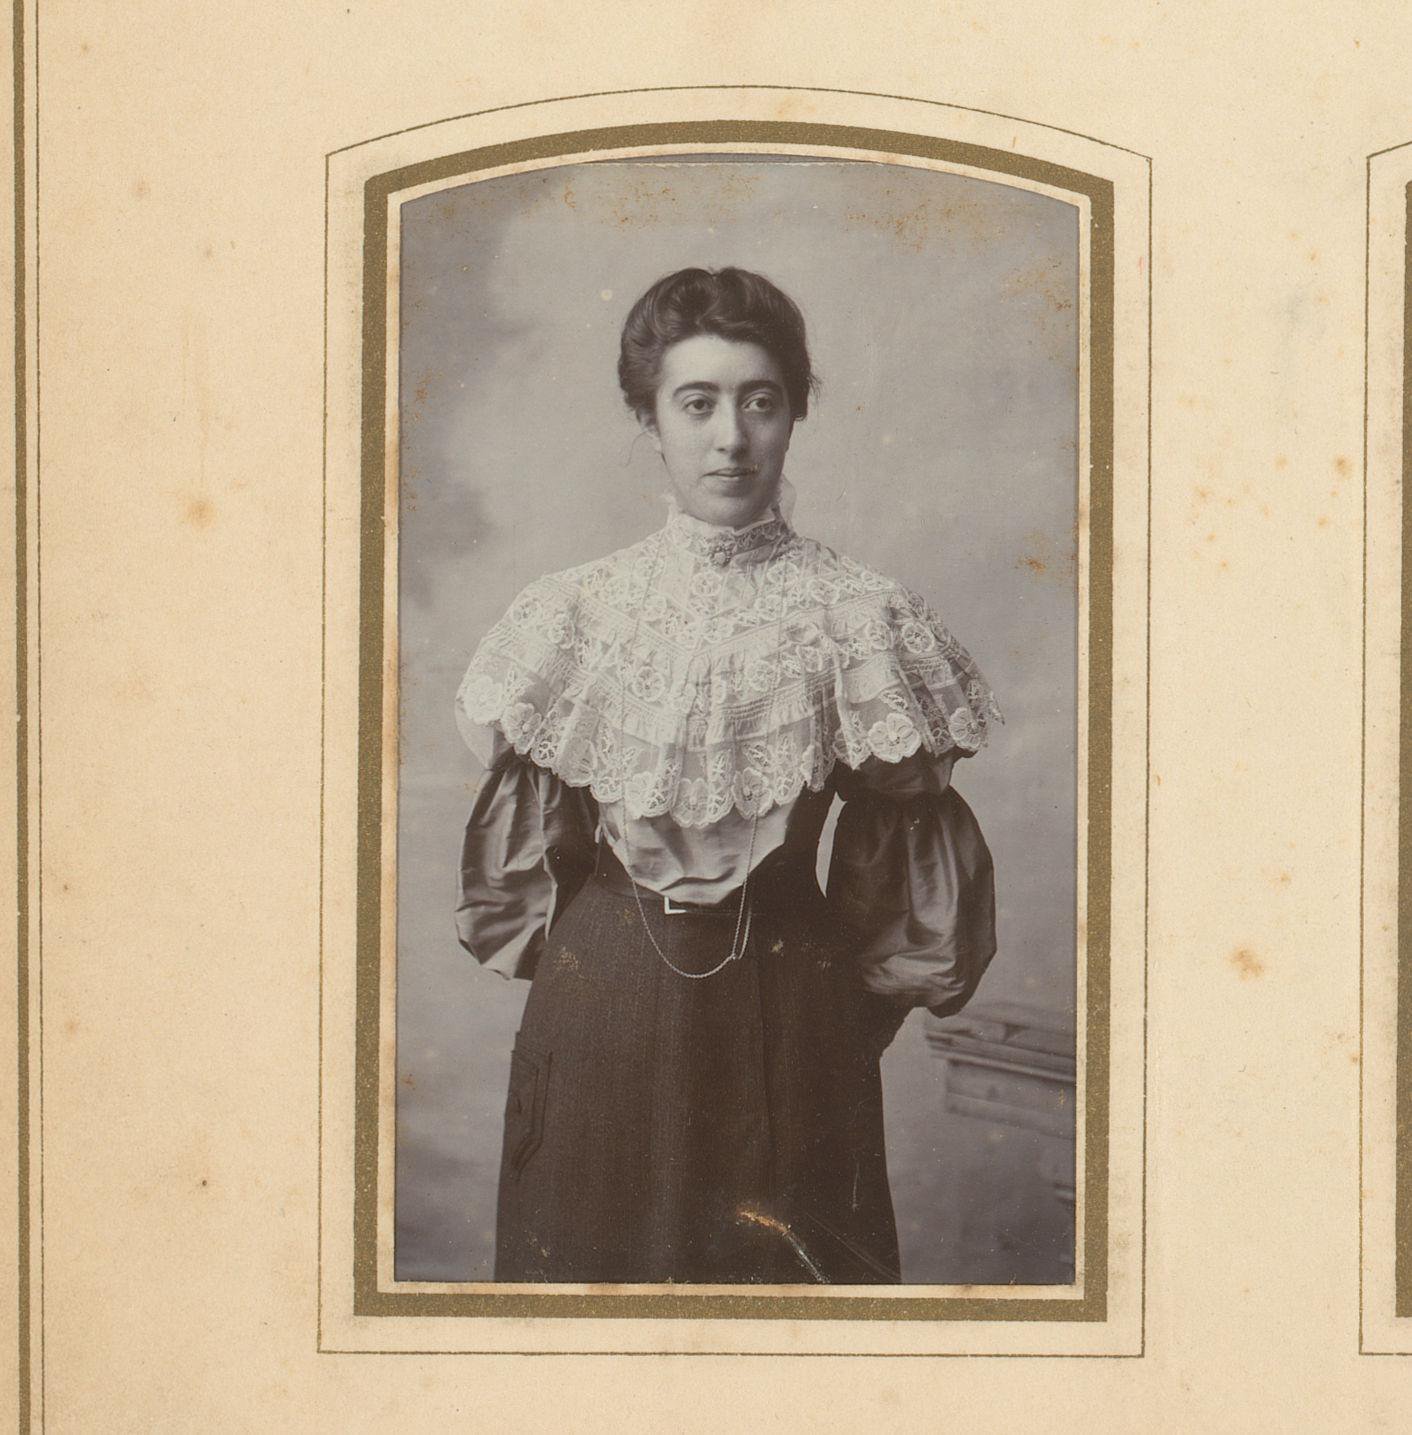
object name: photograph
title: Portret van een staande jonge vrouw met halsketting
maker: hendrik venhuis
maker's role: fotograaf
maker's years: 1866-1938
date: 1904-1926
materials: cardboard, photographic support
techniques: collodion silver print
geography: delfzijl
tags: historical persons - bb - woman, standing figure - aa - female human figure, necklace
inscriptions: inscription: ‘H. Venhuis/ Farmsum/ Delfzijl’